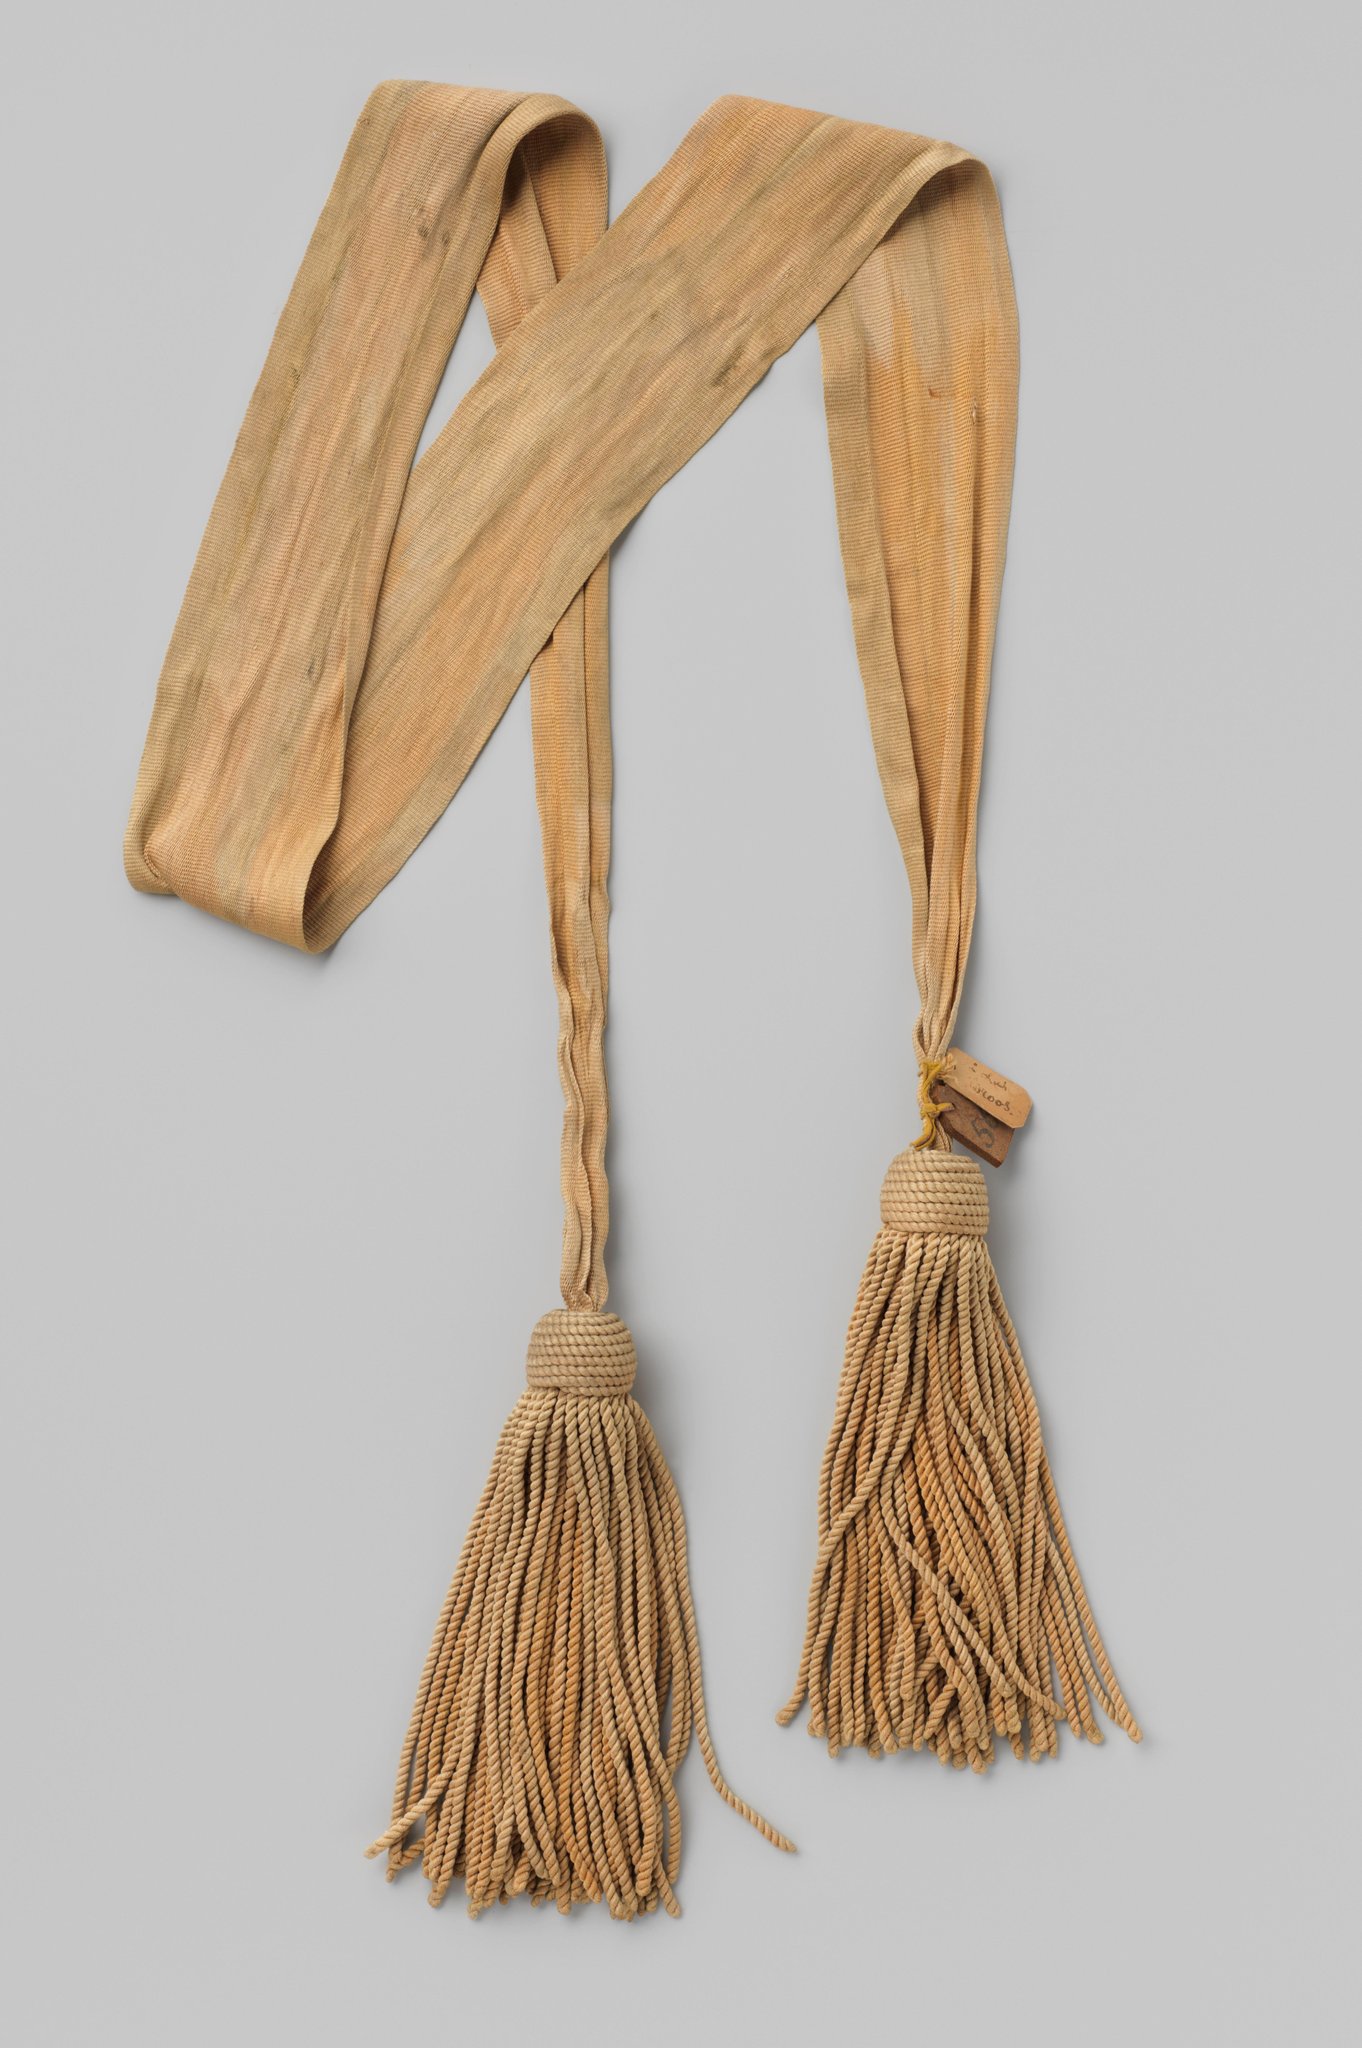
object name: sash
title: Sjerp voor officier Nederlandse leger M. 1815 met kwasten van M. 1860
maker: Anonymous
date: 1815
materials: silk, wood, wool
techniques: knotting, turning, weave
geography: netherlands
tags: 2e luitenant, h.c. broos, noord-hollandse schutterij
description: Sjerp van oranje verfletste zijde, met gaten. In techniek van "Egyptisch vlechtwerk" sjerp werd geknoopt. Aan een zijde, vastgeknoopt aan een stuk touw een achthoekig etiket met de restant van een tekst, 2 luit. Broos. Daaronder vastgeknoopt met oranje zijde, een leren label met aan beide zijde het nummer 56. Aan beide zijdes is de sjerp voorzien van kwasten van dito kleurig met lange franjes. Binnenzijde der kwasten: houten kern met gat, waardoor de sjerp is getrokken. De sjerp is aan beide zijdes voorzien van een ronde, gestikte knoop.